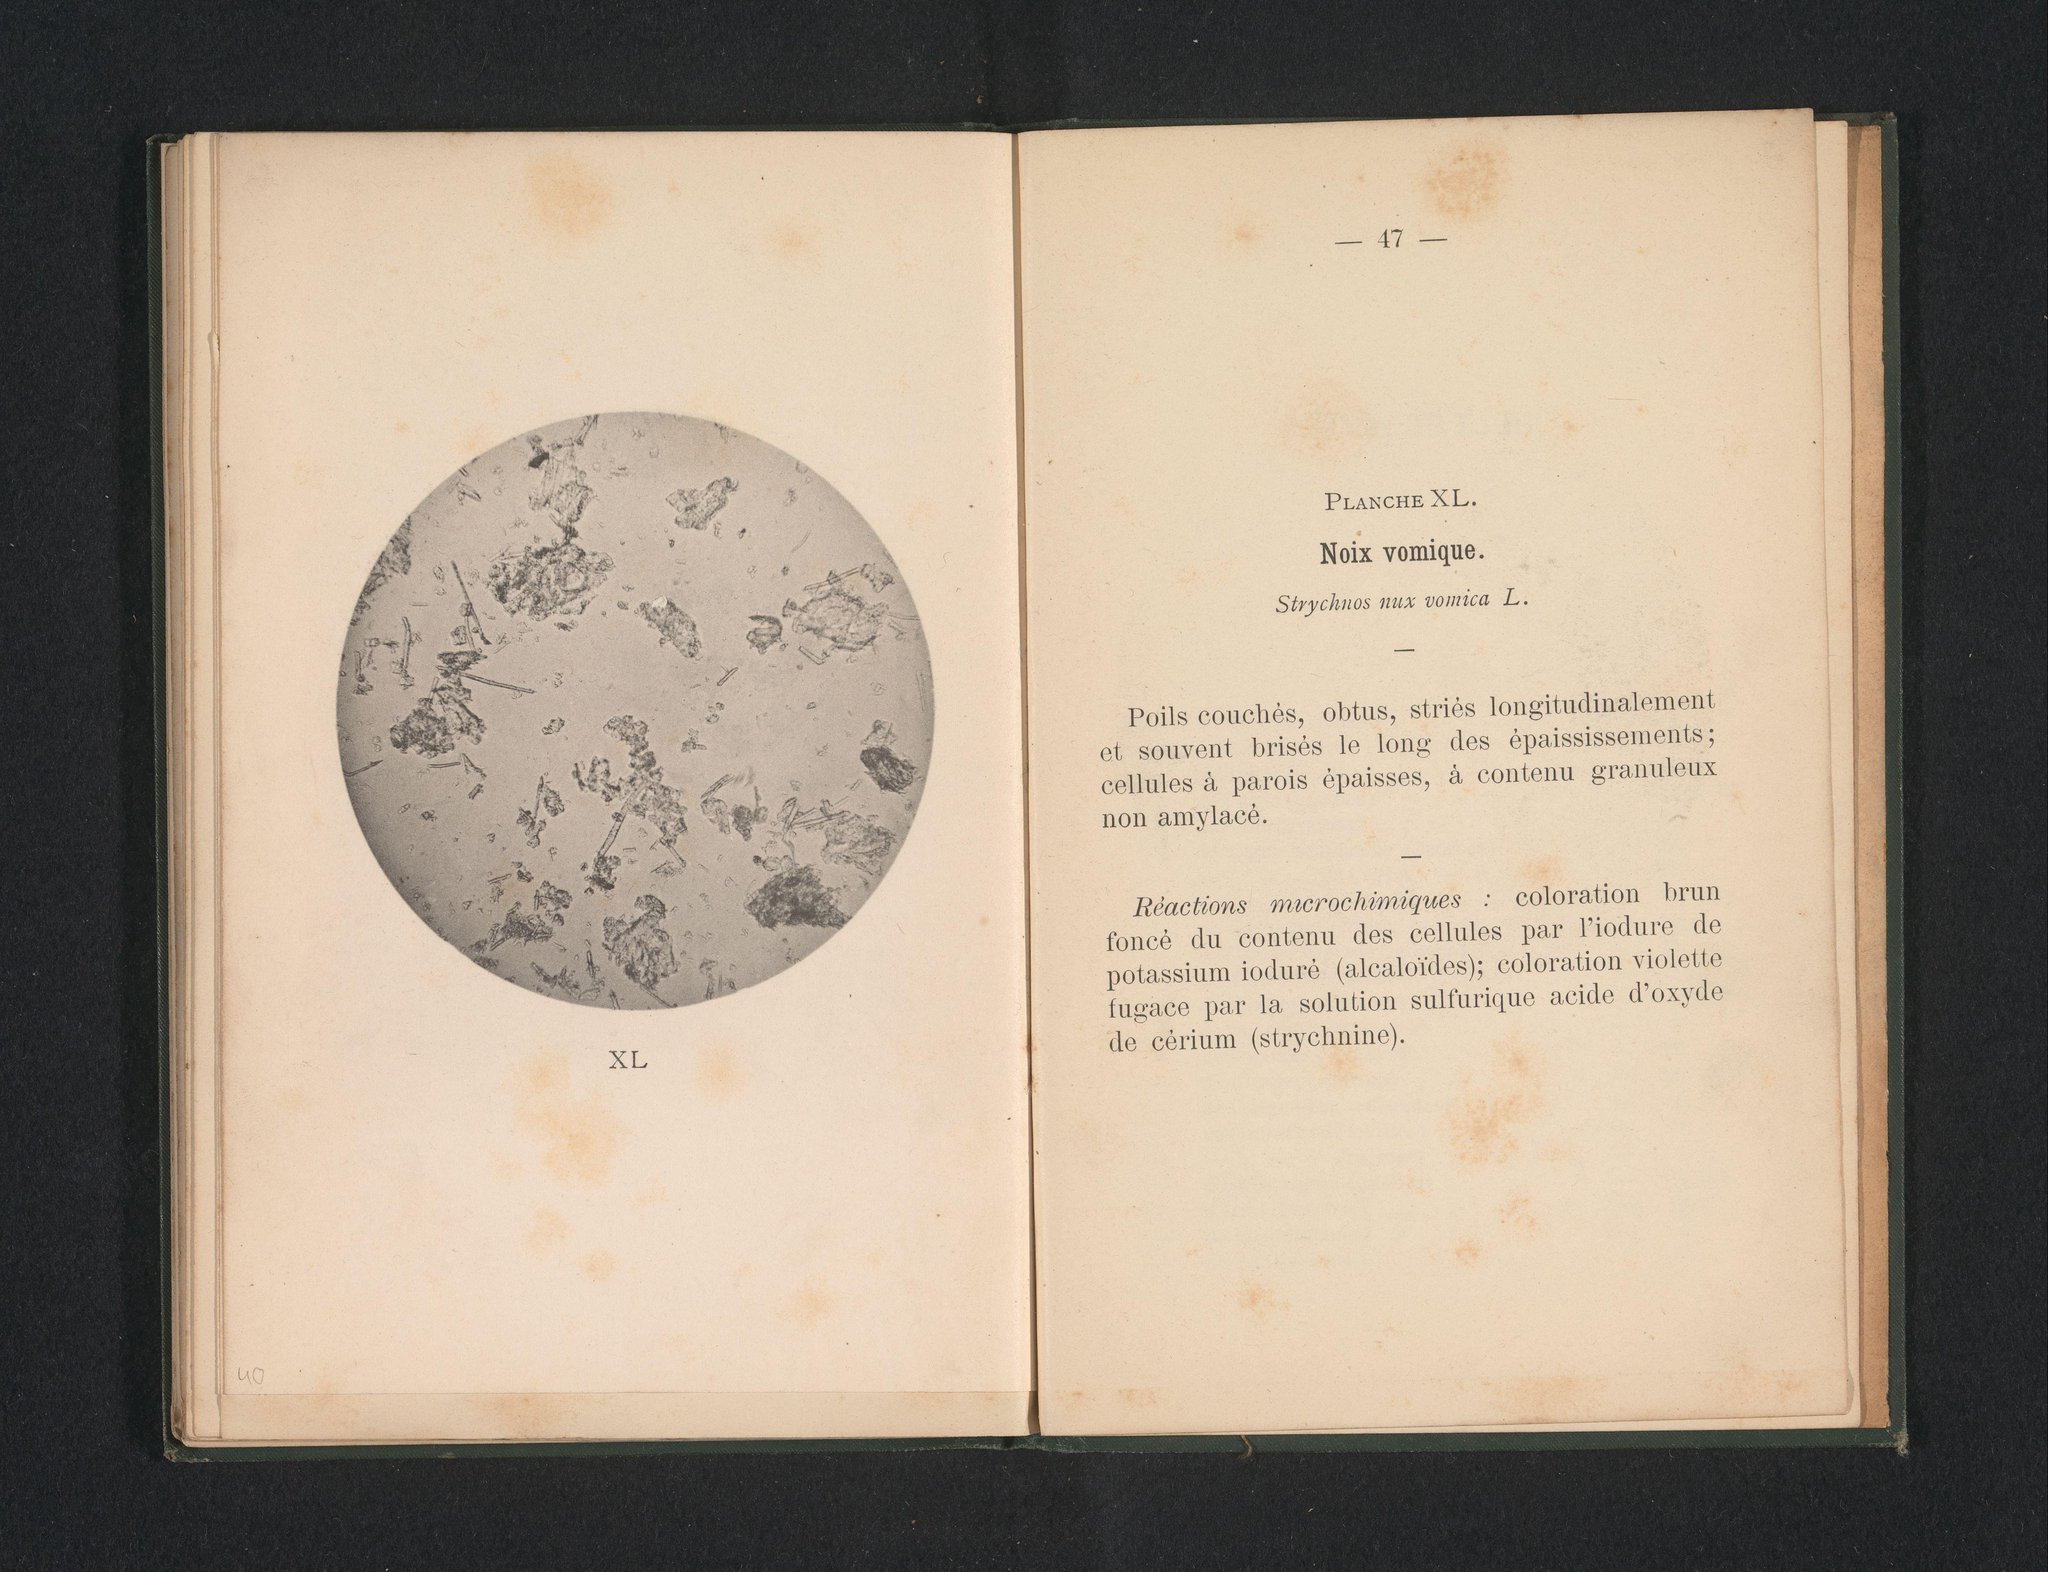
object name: photomechanical print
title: Microscopische weergave van braaknoten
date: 1891-1896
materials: paper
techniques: photograph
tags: microscope (+ scientific research)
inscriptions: number: ‘XL’